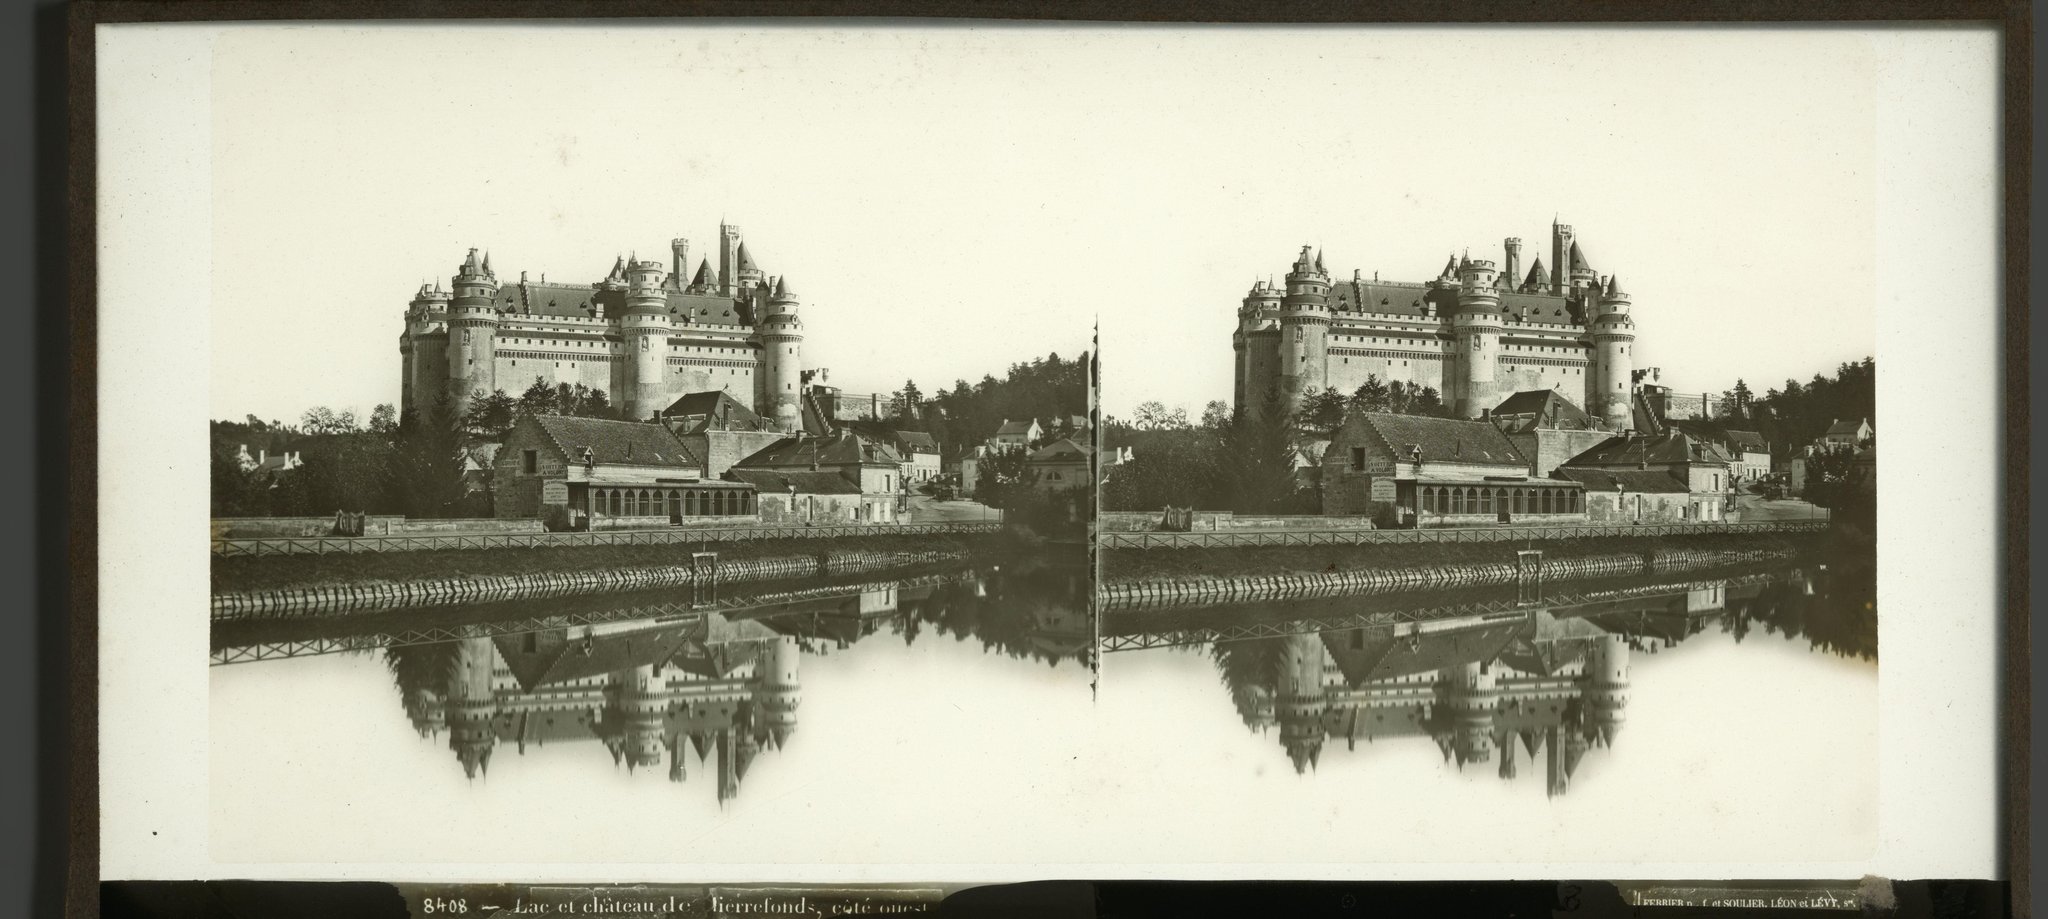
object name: stereoscopic photograph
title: Gezicht op het Kasteel van Pierrefonds, Frankrijk, met op de voorgrond een meer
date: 1860-1870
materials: glass, paper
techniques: slide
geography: pierrefonds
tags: castle, lake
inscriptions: number: ‘8408’